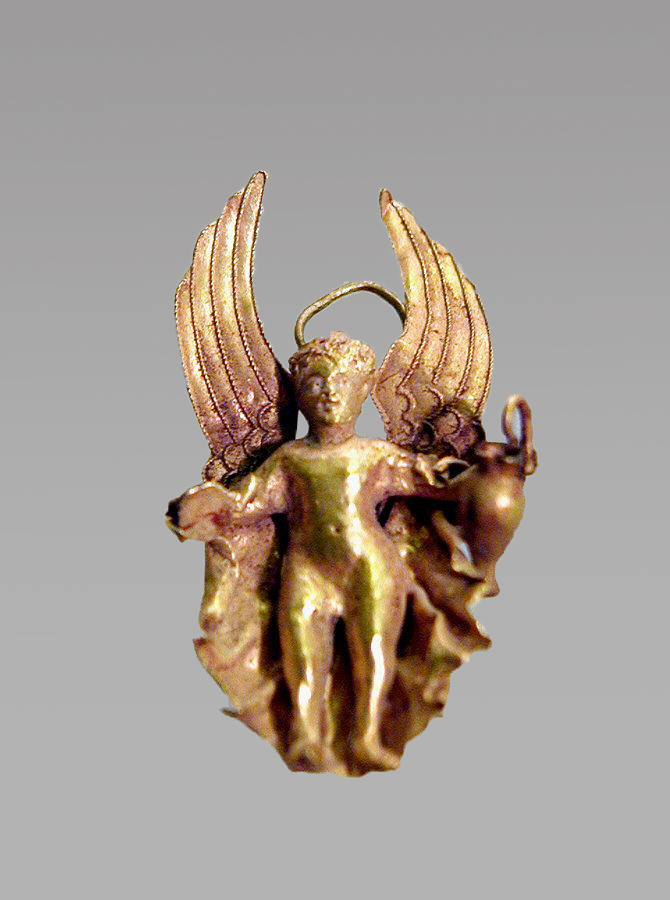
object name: earring with eros, pair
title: Pair of gold earrings with pendant Erotes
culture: greek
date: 300-1 BCE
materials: gold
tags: eros